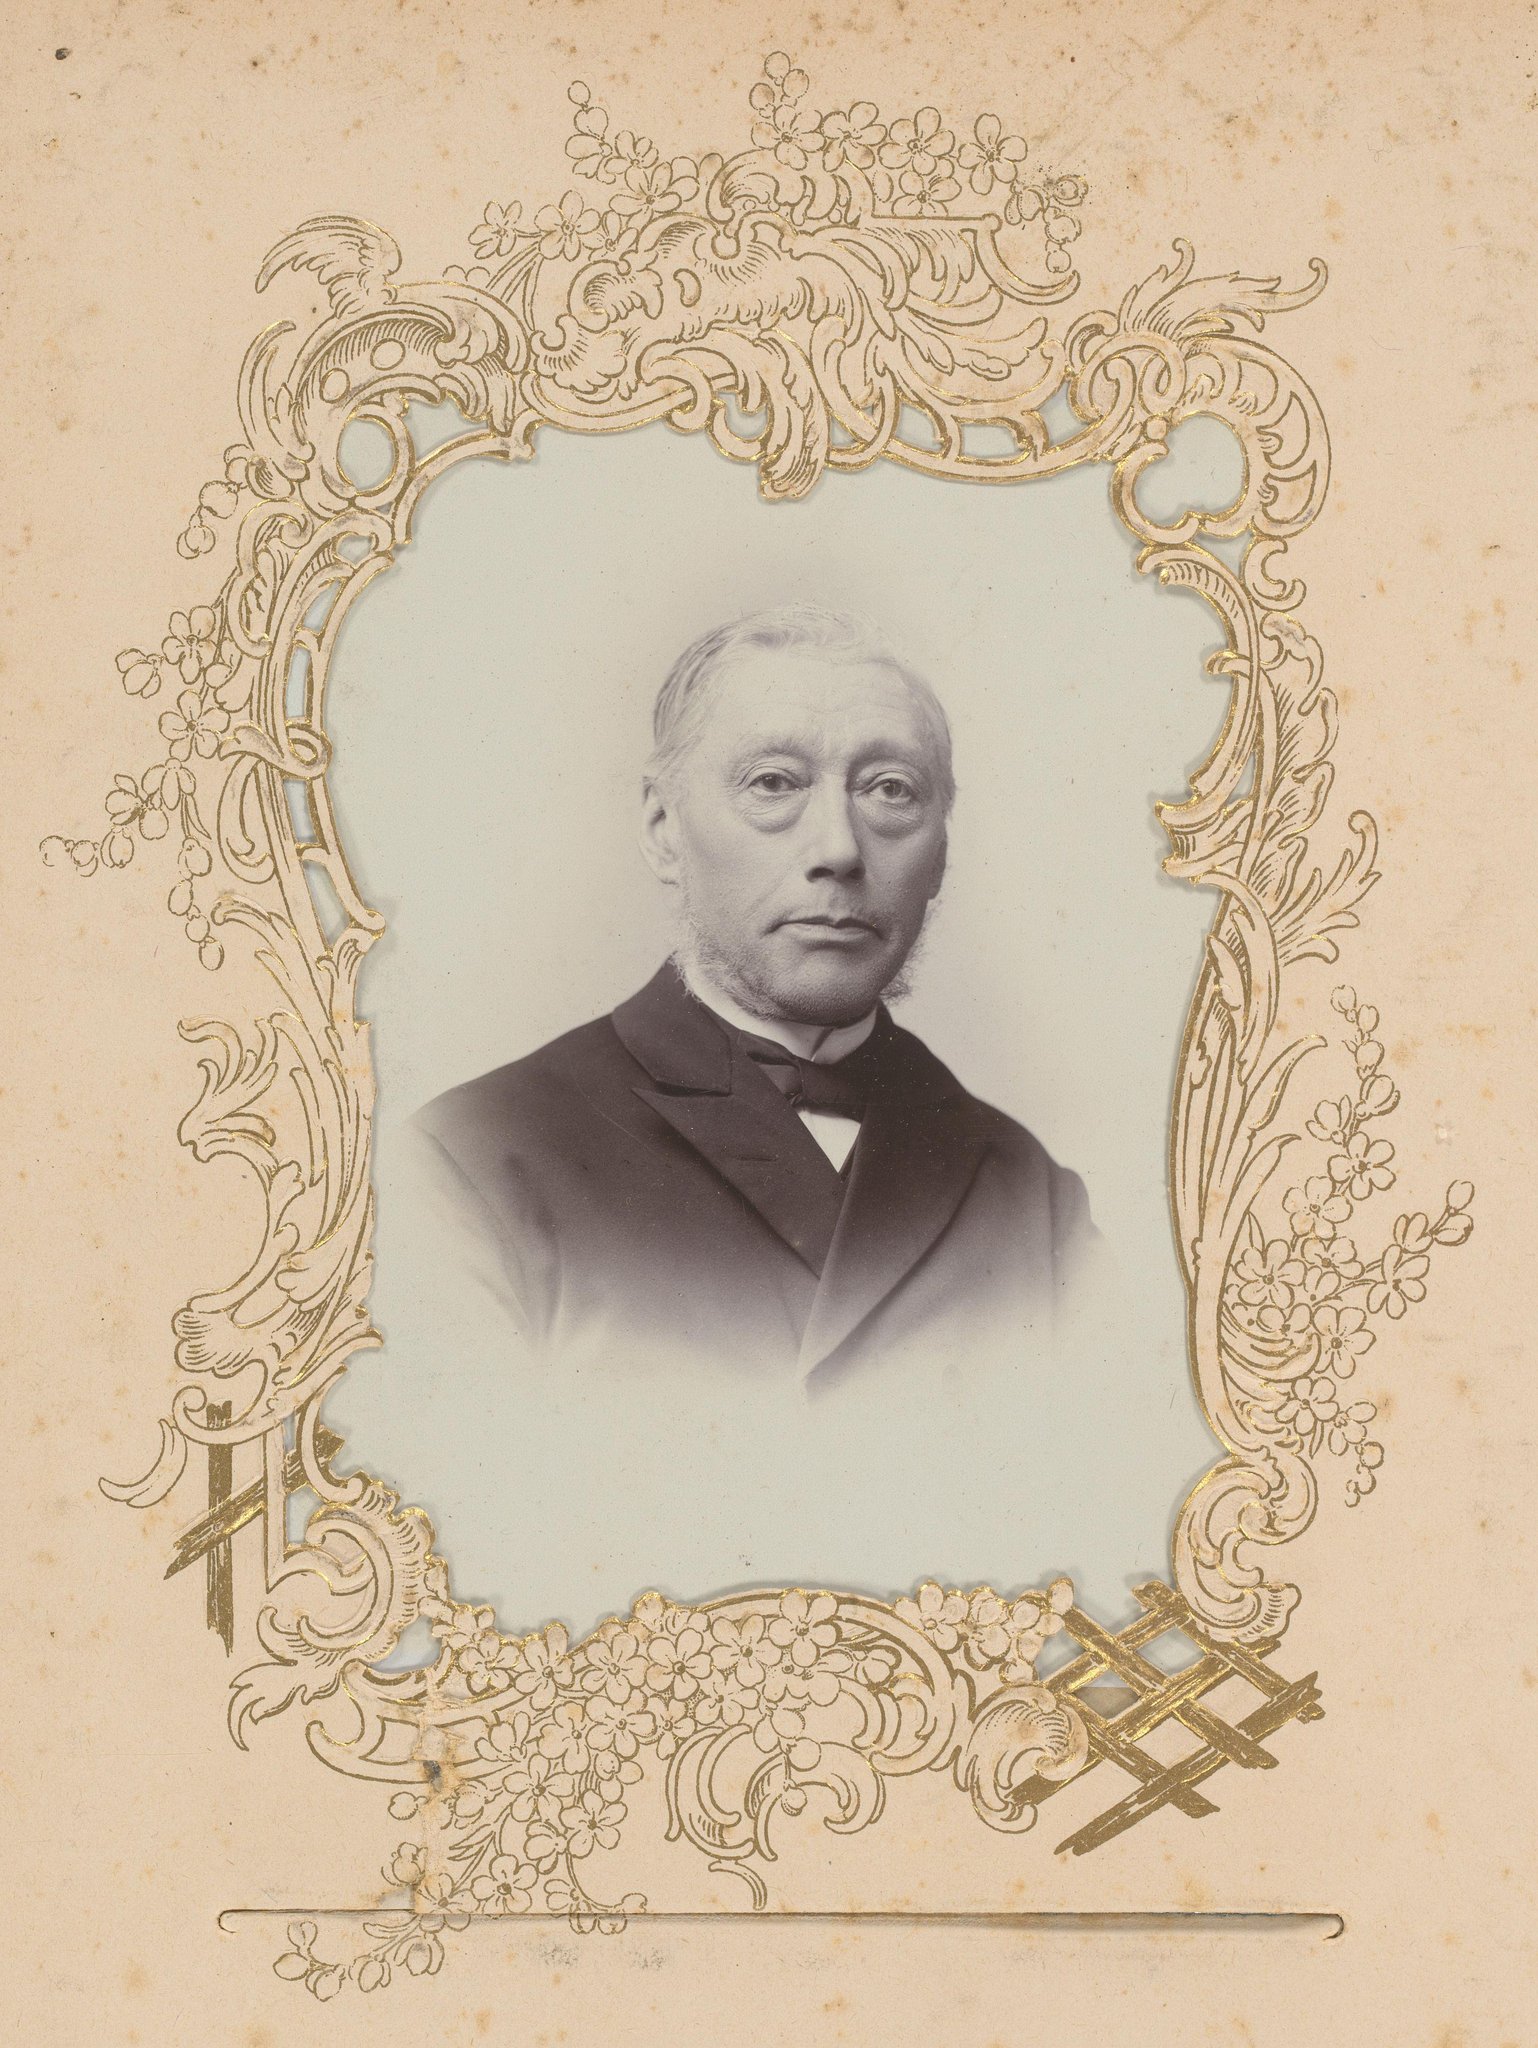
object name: photograph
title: Portret van een man met bakkebaarden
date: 1885-1906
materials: cardboard, photographic support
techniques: collodion silver print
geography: amsterdam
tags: historical persons, old man